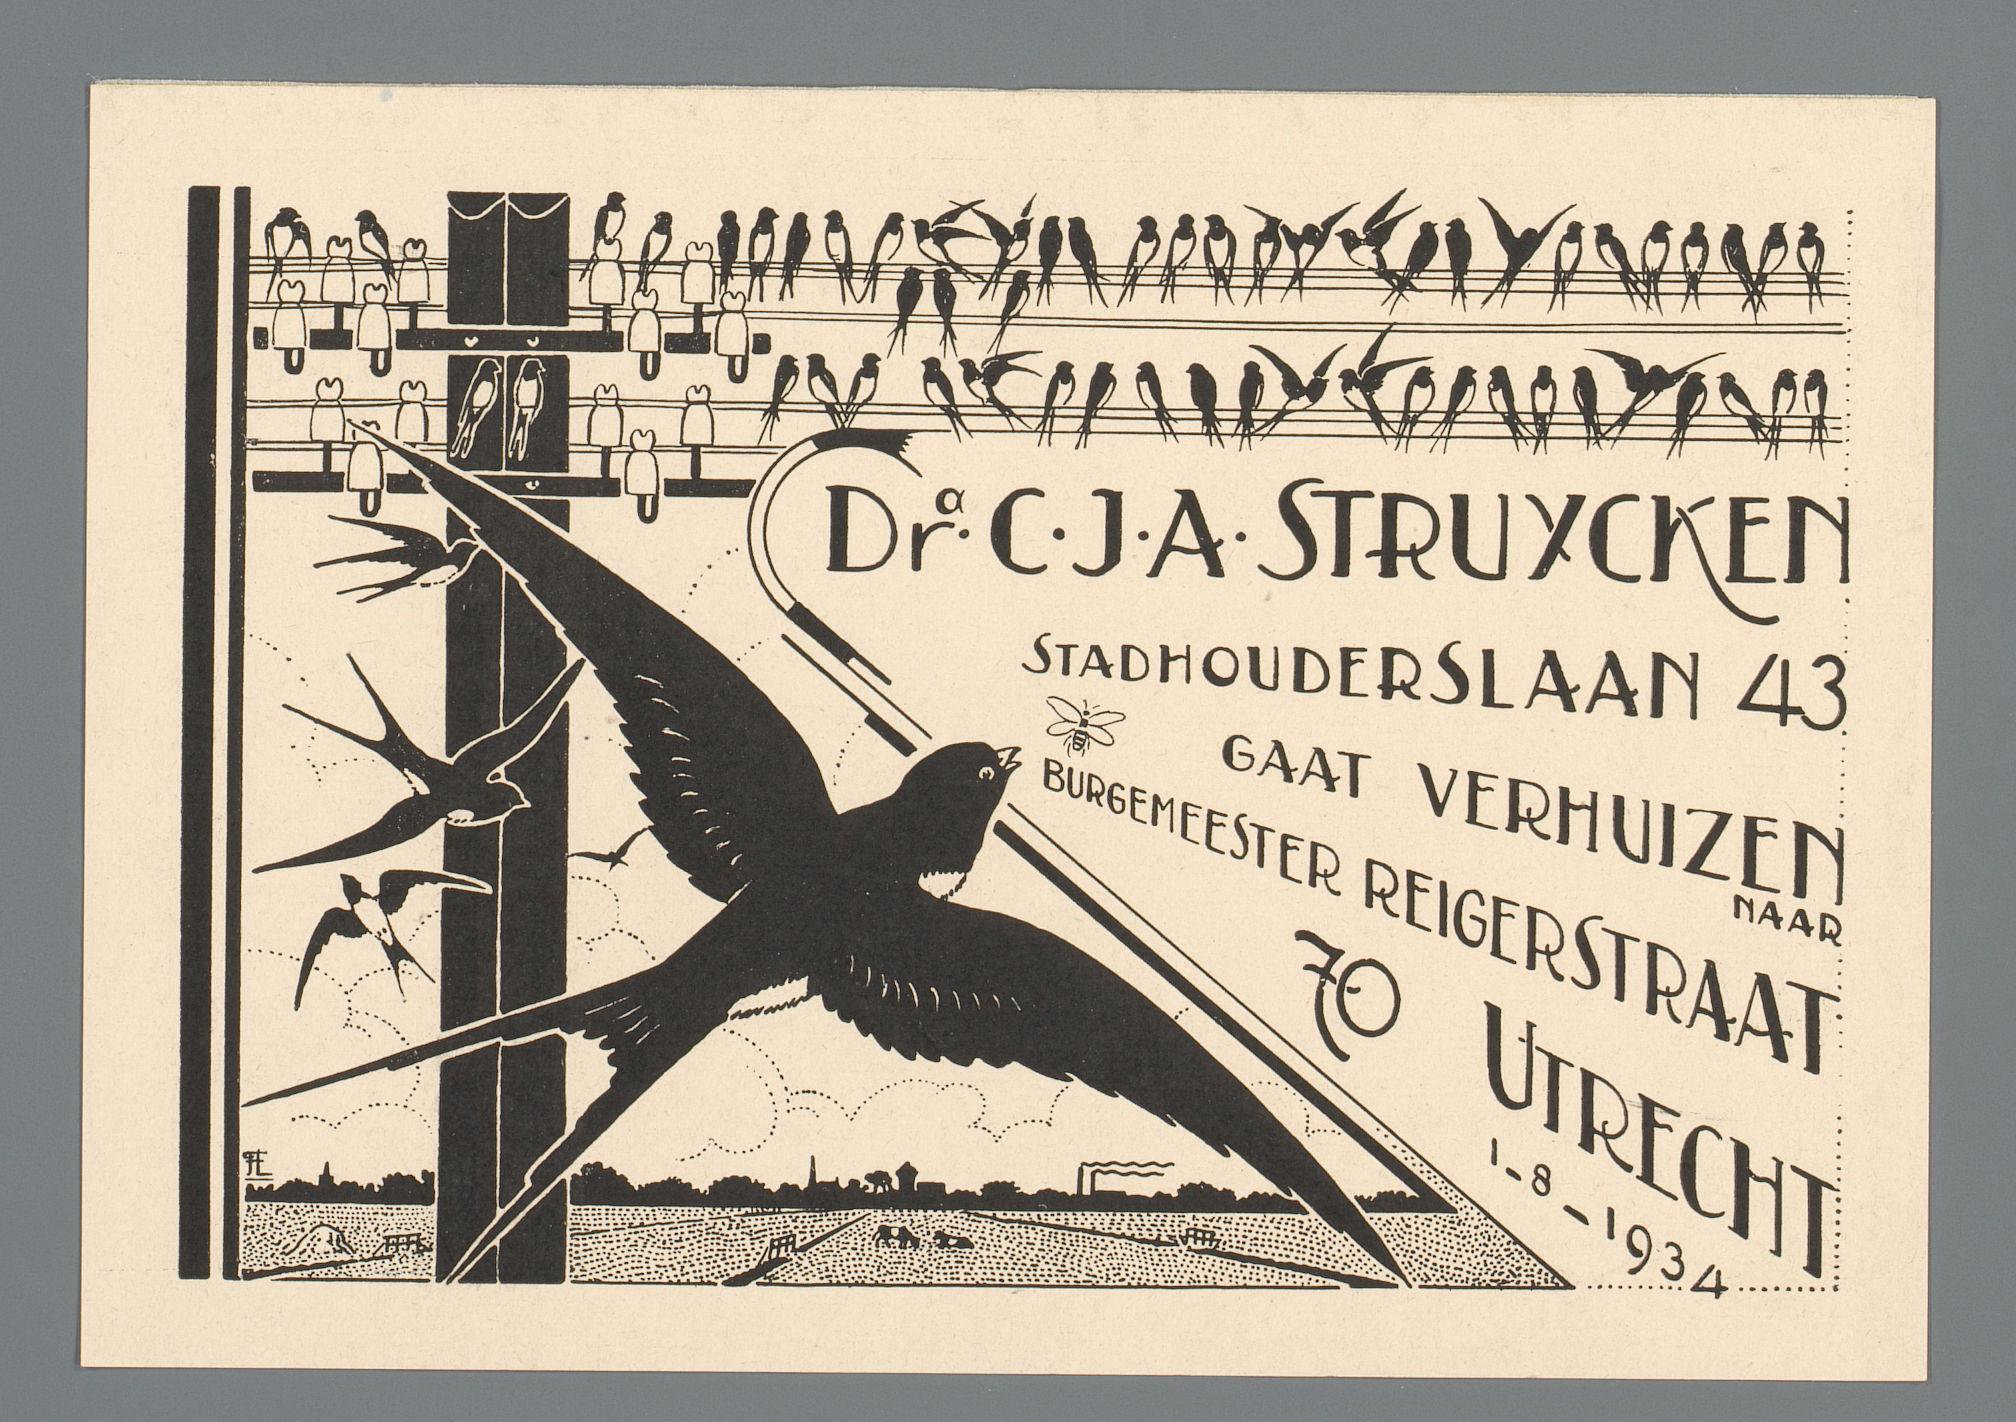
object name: photomechanical print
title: Verhuisaankondiging van dr. C.J.A. Struycken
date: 1934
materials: paper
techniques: printing block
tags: moving (house), song-birds: swallow, utrecht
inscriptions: collector's mark: Lugt 2228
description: De verwijzing naar F. Lazaron is gebaseerd op een vermelding als zodanig bij deze zelfde prent, bij MaNDA (Magyar Nemzeti Digitális Archívum). Bij gebrek aan gegevens over de vervaardiger is voor de bepaling van de rechten van dit object gebruik gemaakt van de vervaardigingsdatum.